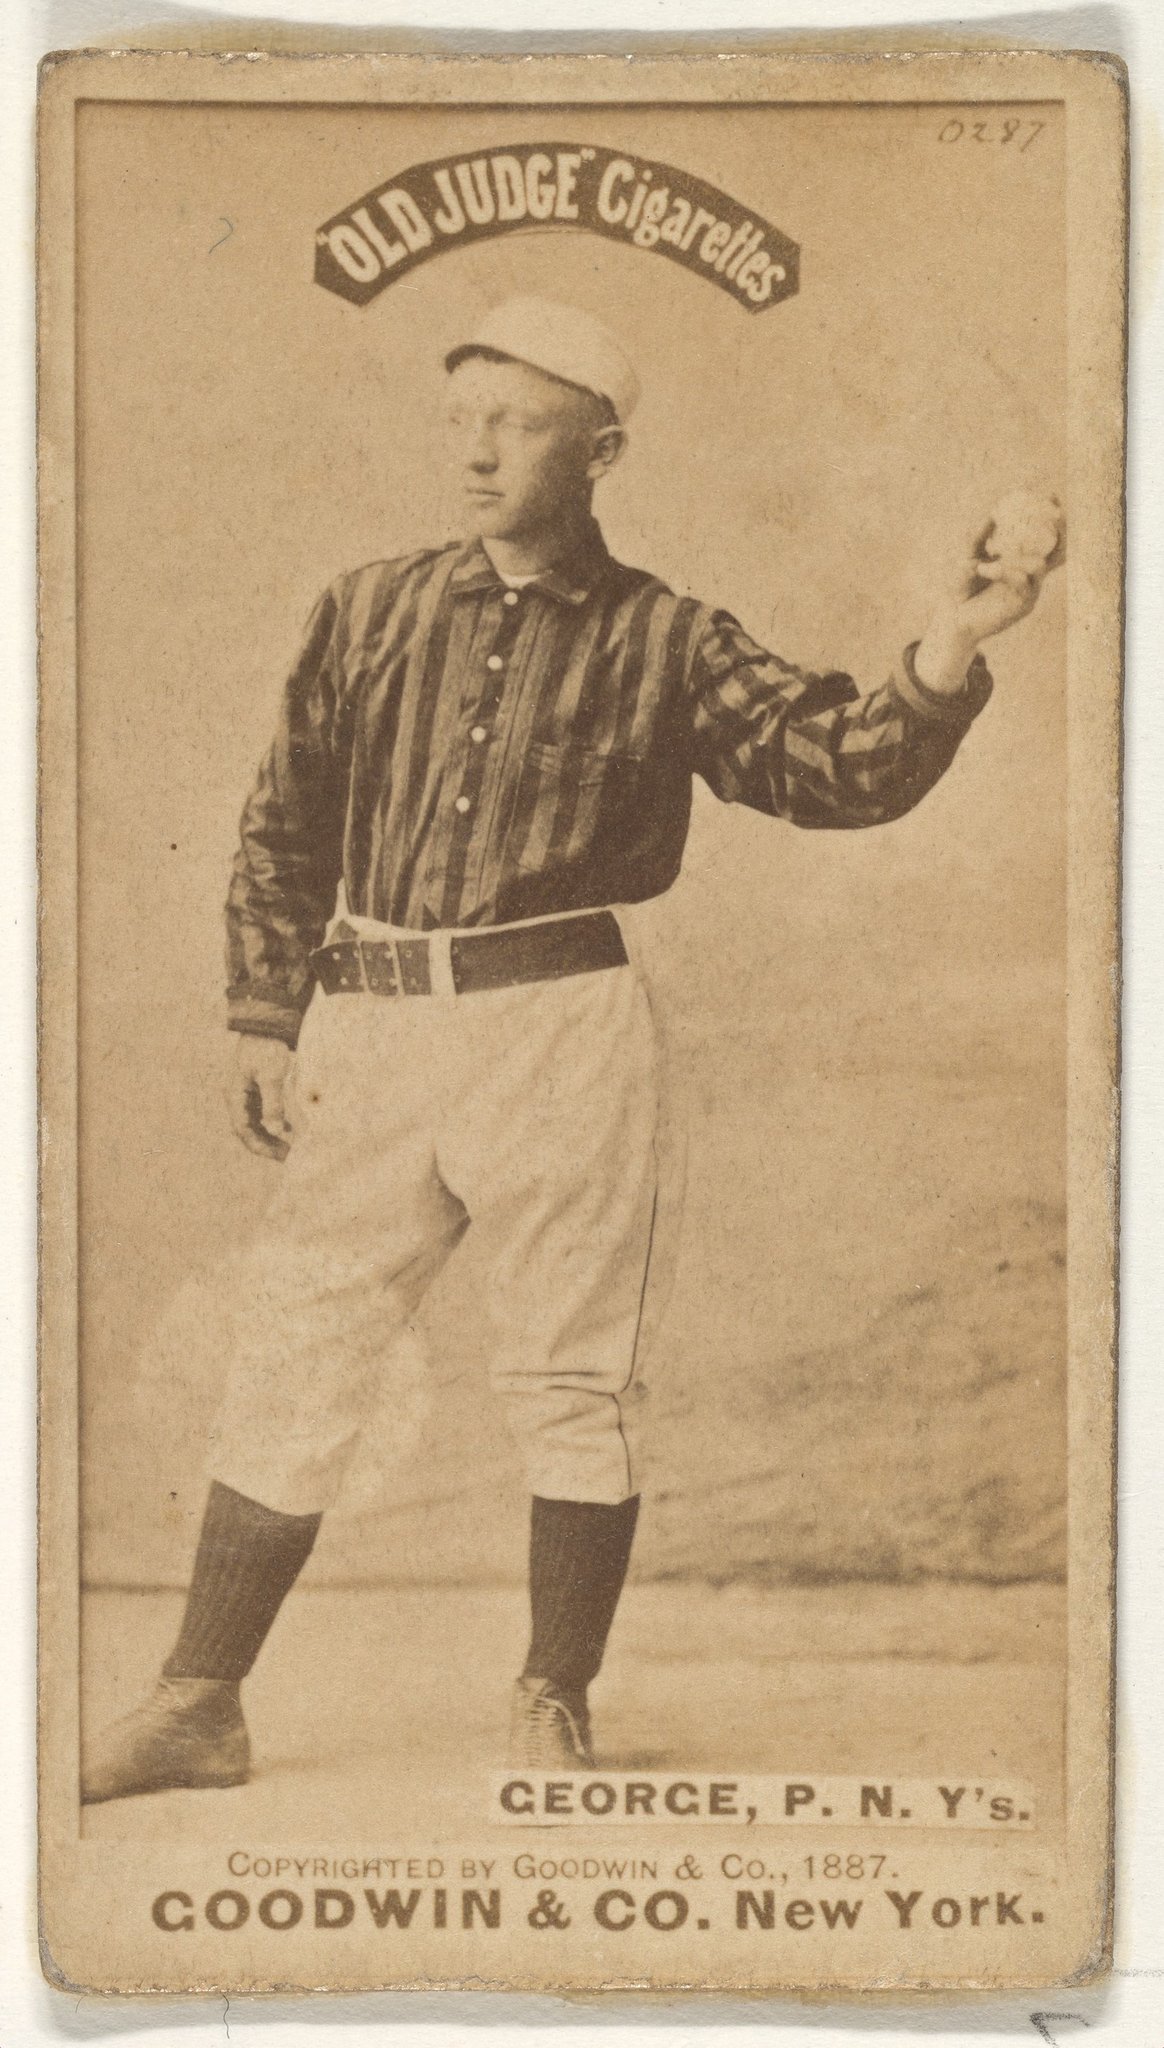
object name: baseball card, photograph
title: Bill George, Pitcher, New York, from the Old Judge series (N172) for Old Judge Cigarettes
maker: goodwin & company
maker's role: publisher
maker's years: 1850-1950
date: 1887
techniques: albumen silver print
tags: men,portraits,baseball,athletes